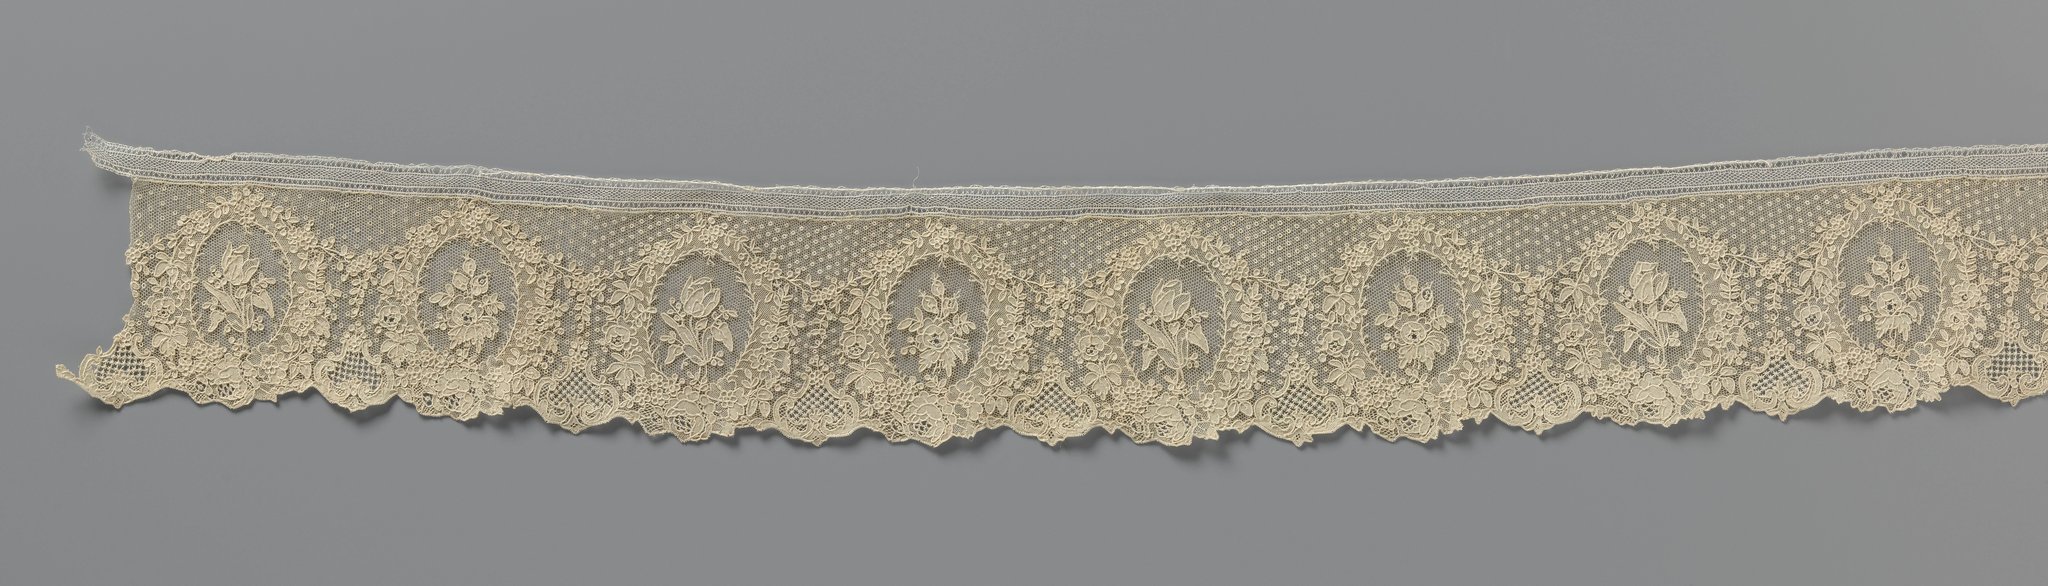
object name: strip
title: Strook naaldkant met tulp en rozentak in medaillons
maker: Anonymous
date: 1860-1870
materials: linen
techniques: lace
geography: alençon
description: Strook naturelkleurige naaldkant: Alençon-kant. Patroon met een repetitief motief van medaillons op een fijne zeshoekige maasgrond, die is bezaaid met moesjes. In de medaillons om en om een tulp en een rozentak. De buitenrand van de medaillons bestaat uit veelsoortige bloemen en bladeren die naar onder toe groter worden. Siergronden in een enkele bloem en in de door c-voluten gevormde ruimte tussen de medaillons. De onderzijde is afgewerkt met een schulpenrand die voortkomt uit het patroon. De bovenzijde is afgezet met een rand kloskant.